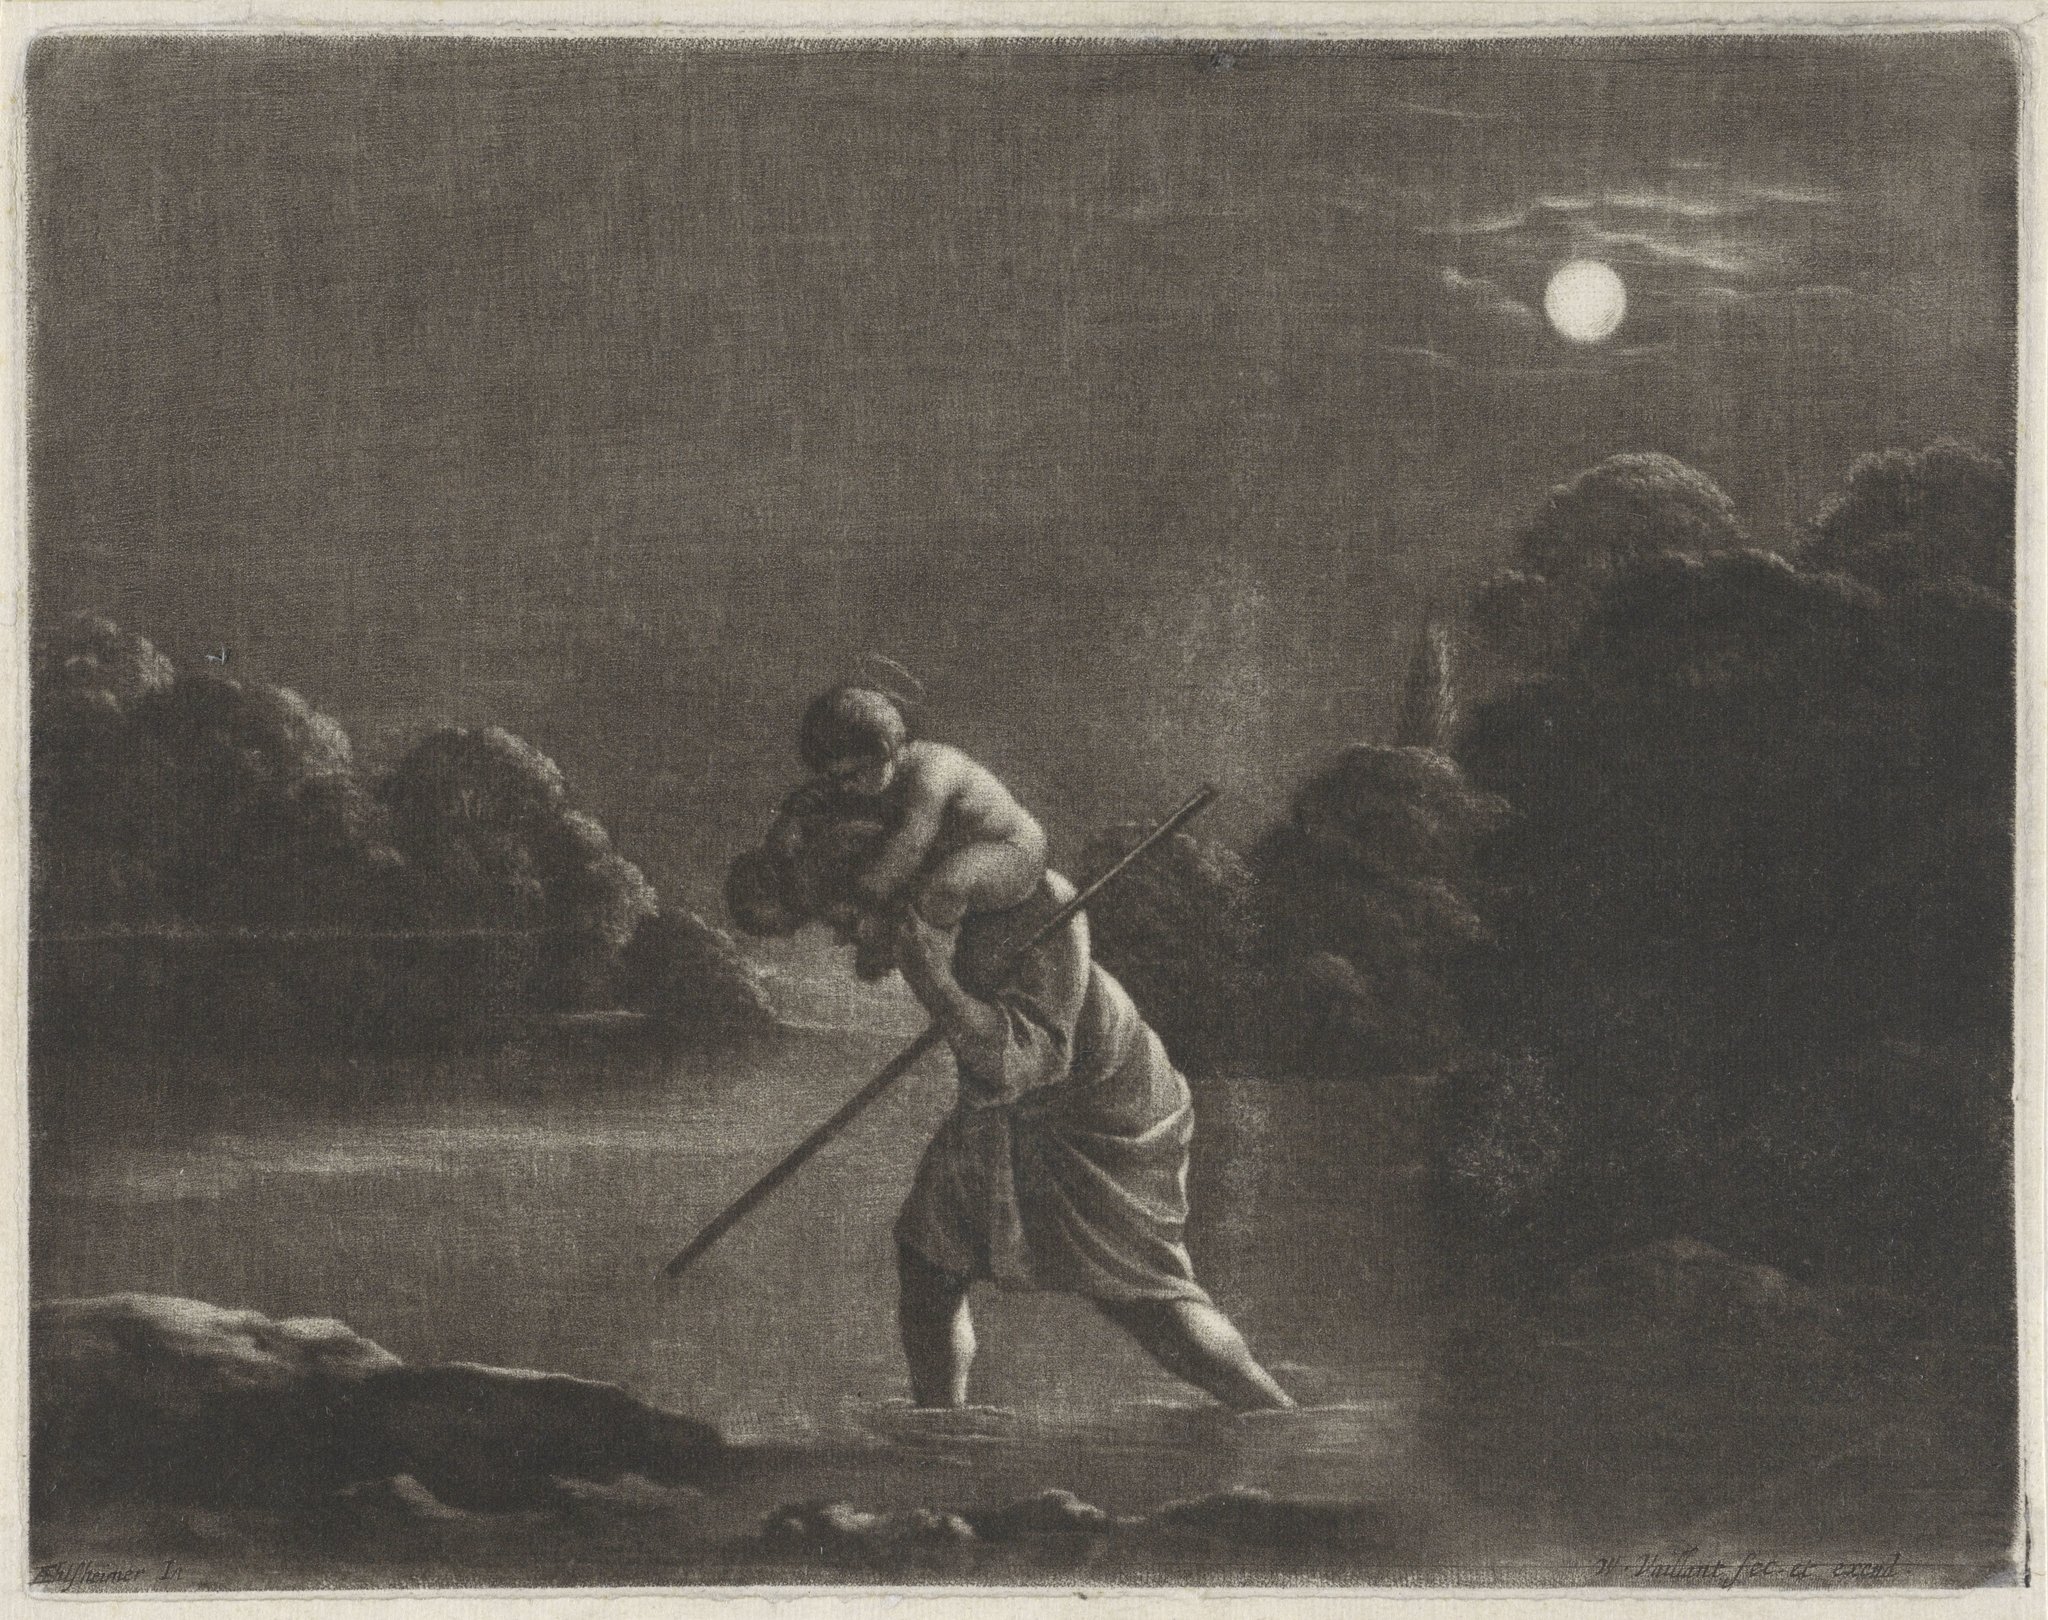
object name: print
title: H. Christoffel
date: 1658-1677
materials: paper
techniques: mezzotint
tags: the giant and martyr christophorus; possible attributes: palm-tree (with bunches of dates, or withered), infant christ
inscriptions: collector's mark: Lugt 2228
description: De H. Christoffel waadt bij het licht van de maan door een rivier met het Christuskind op zijn schouders.